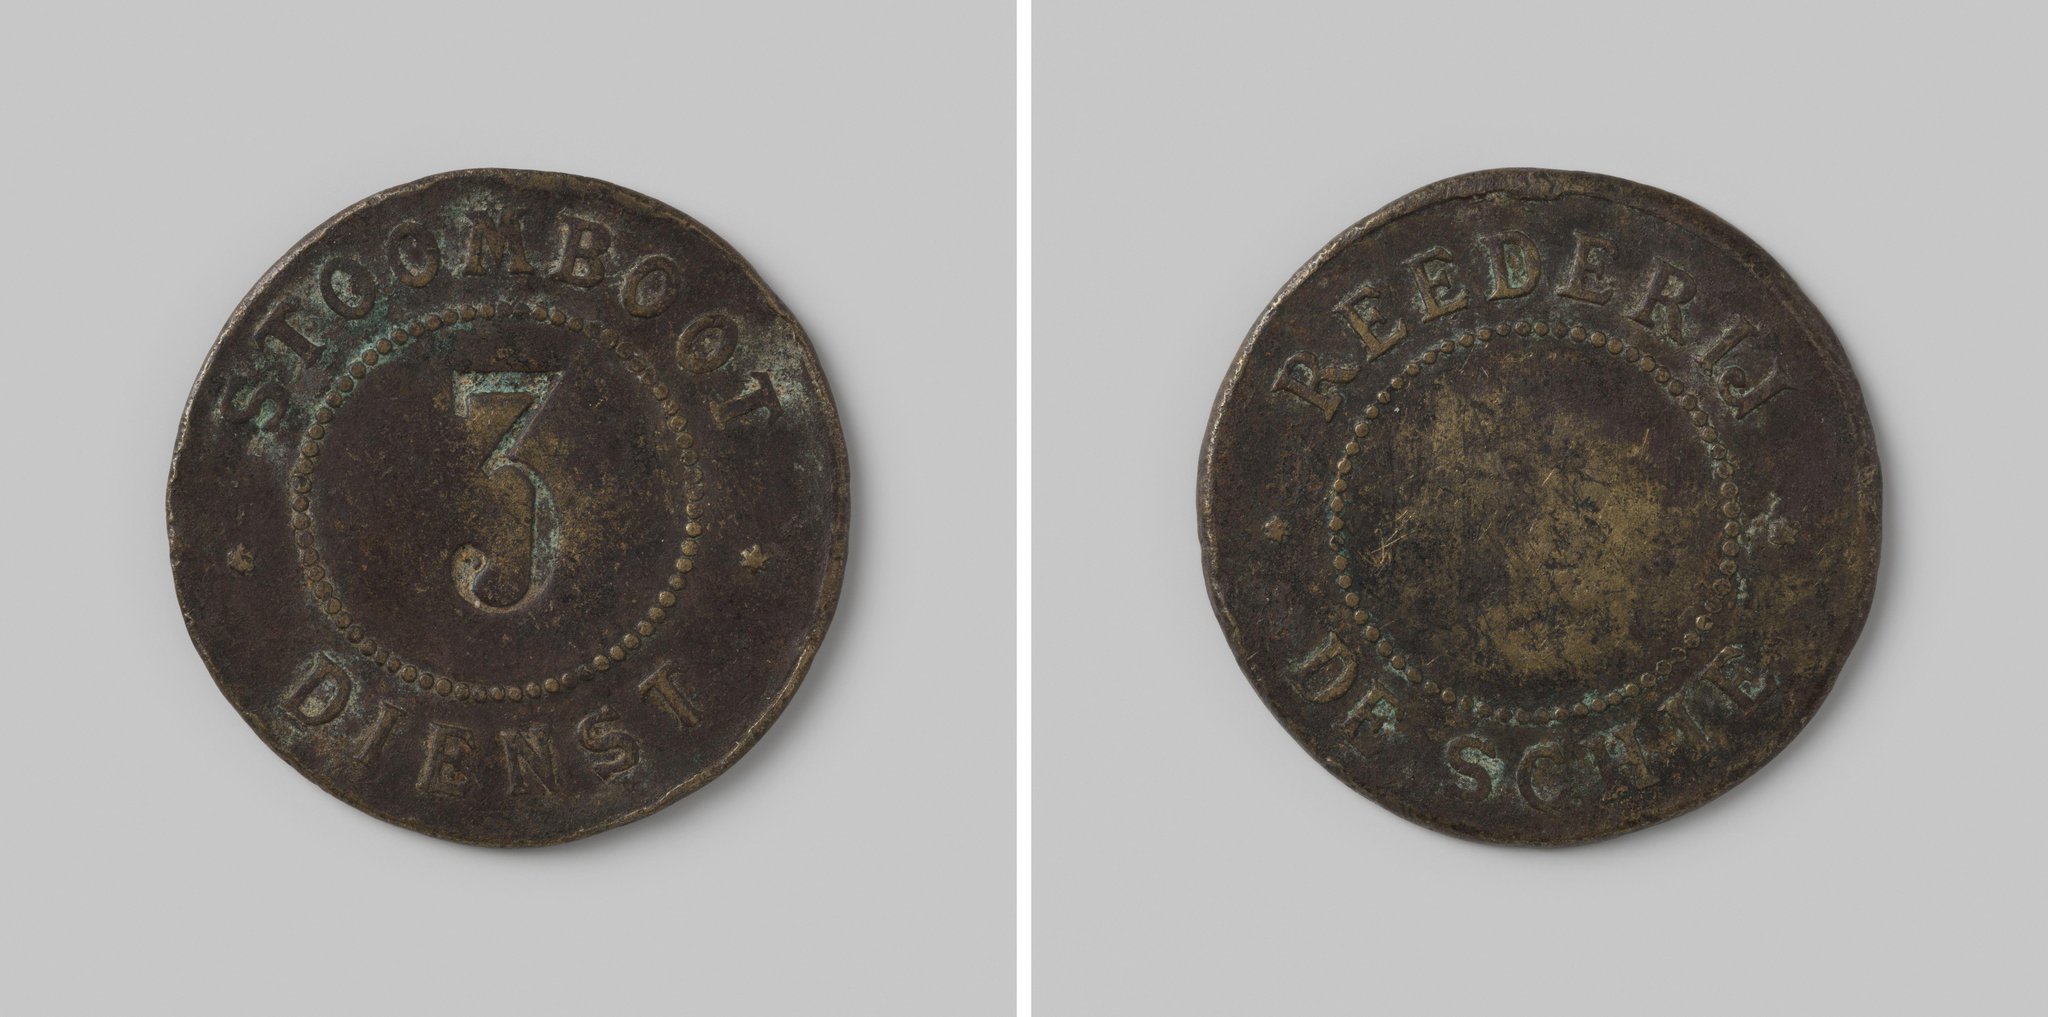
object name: history medal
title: Penning van Rederij De Schie, stoomboot dienst 3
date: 1860-1915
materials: brass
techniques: printing, striking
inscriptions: circumscription: ‘REEDERIJ - DE SCHIE’, circumscription: ‘STOOMBOOT - DIENST’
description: Messing penning, op de voorzijde een blank veld met omschrift, op de keerzijde een blank veld, ingestempeld "3", met omschrift.